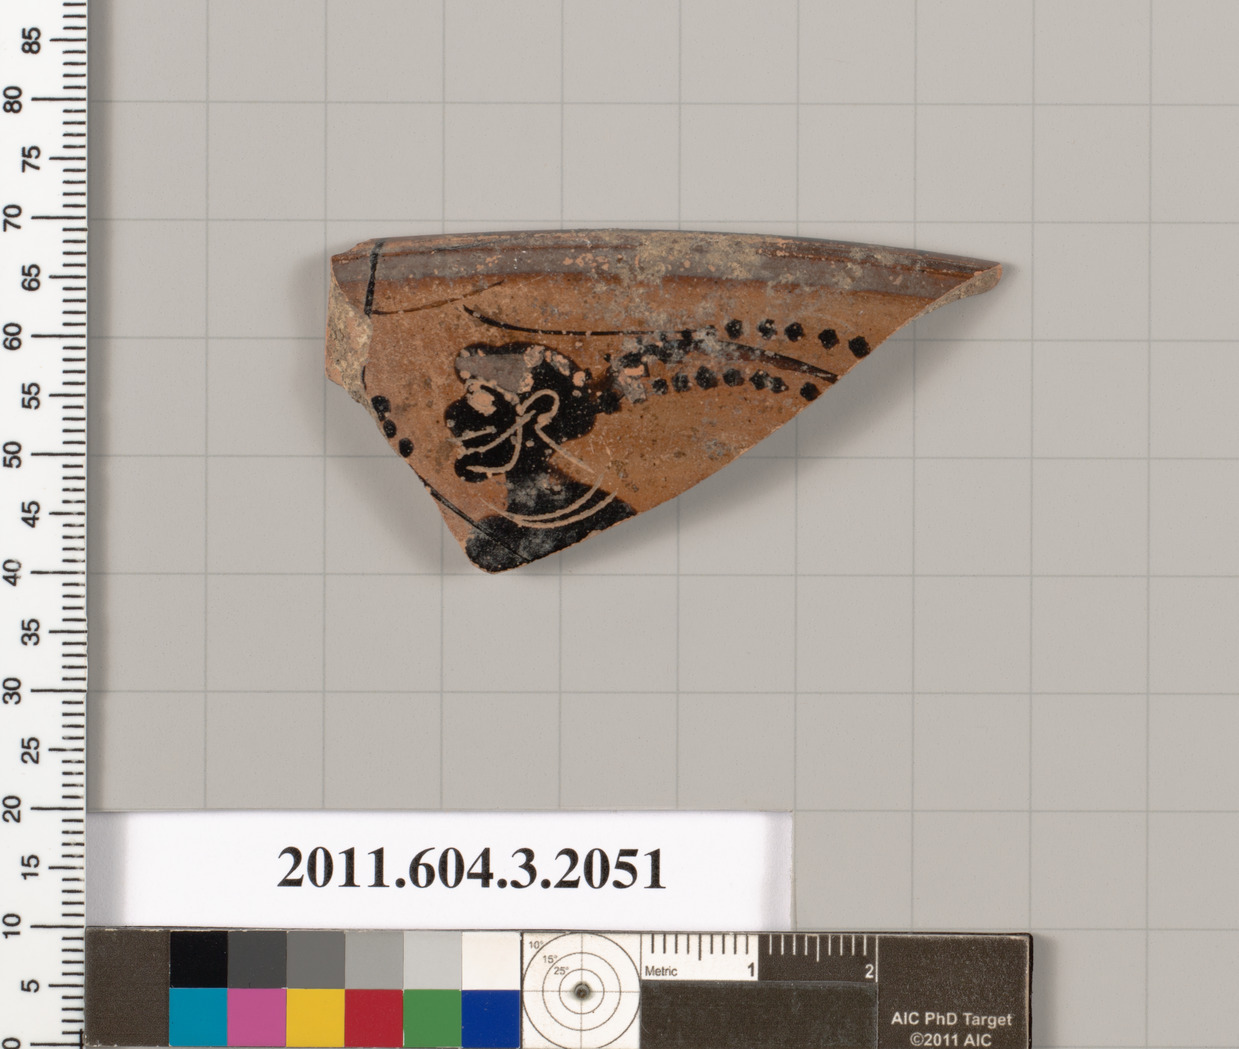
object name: kylix fragment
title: Terracotta rim fragment of a kylix (drinking cup)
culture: greek, attic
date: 500-468 BCE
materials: terracotta